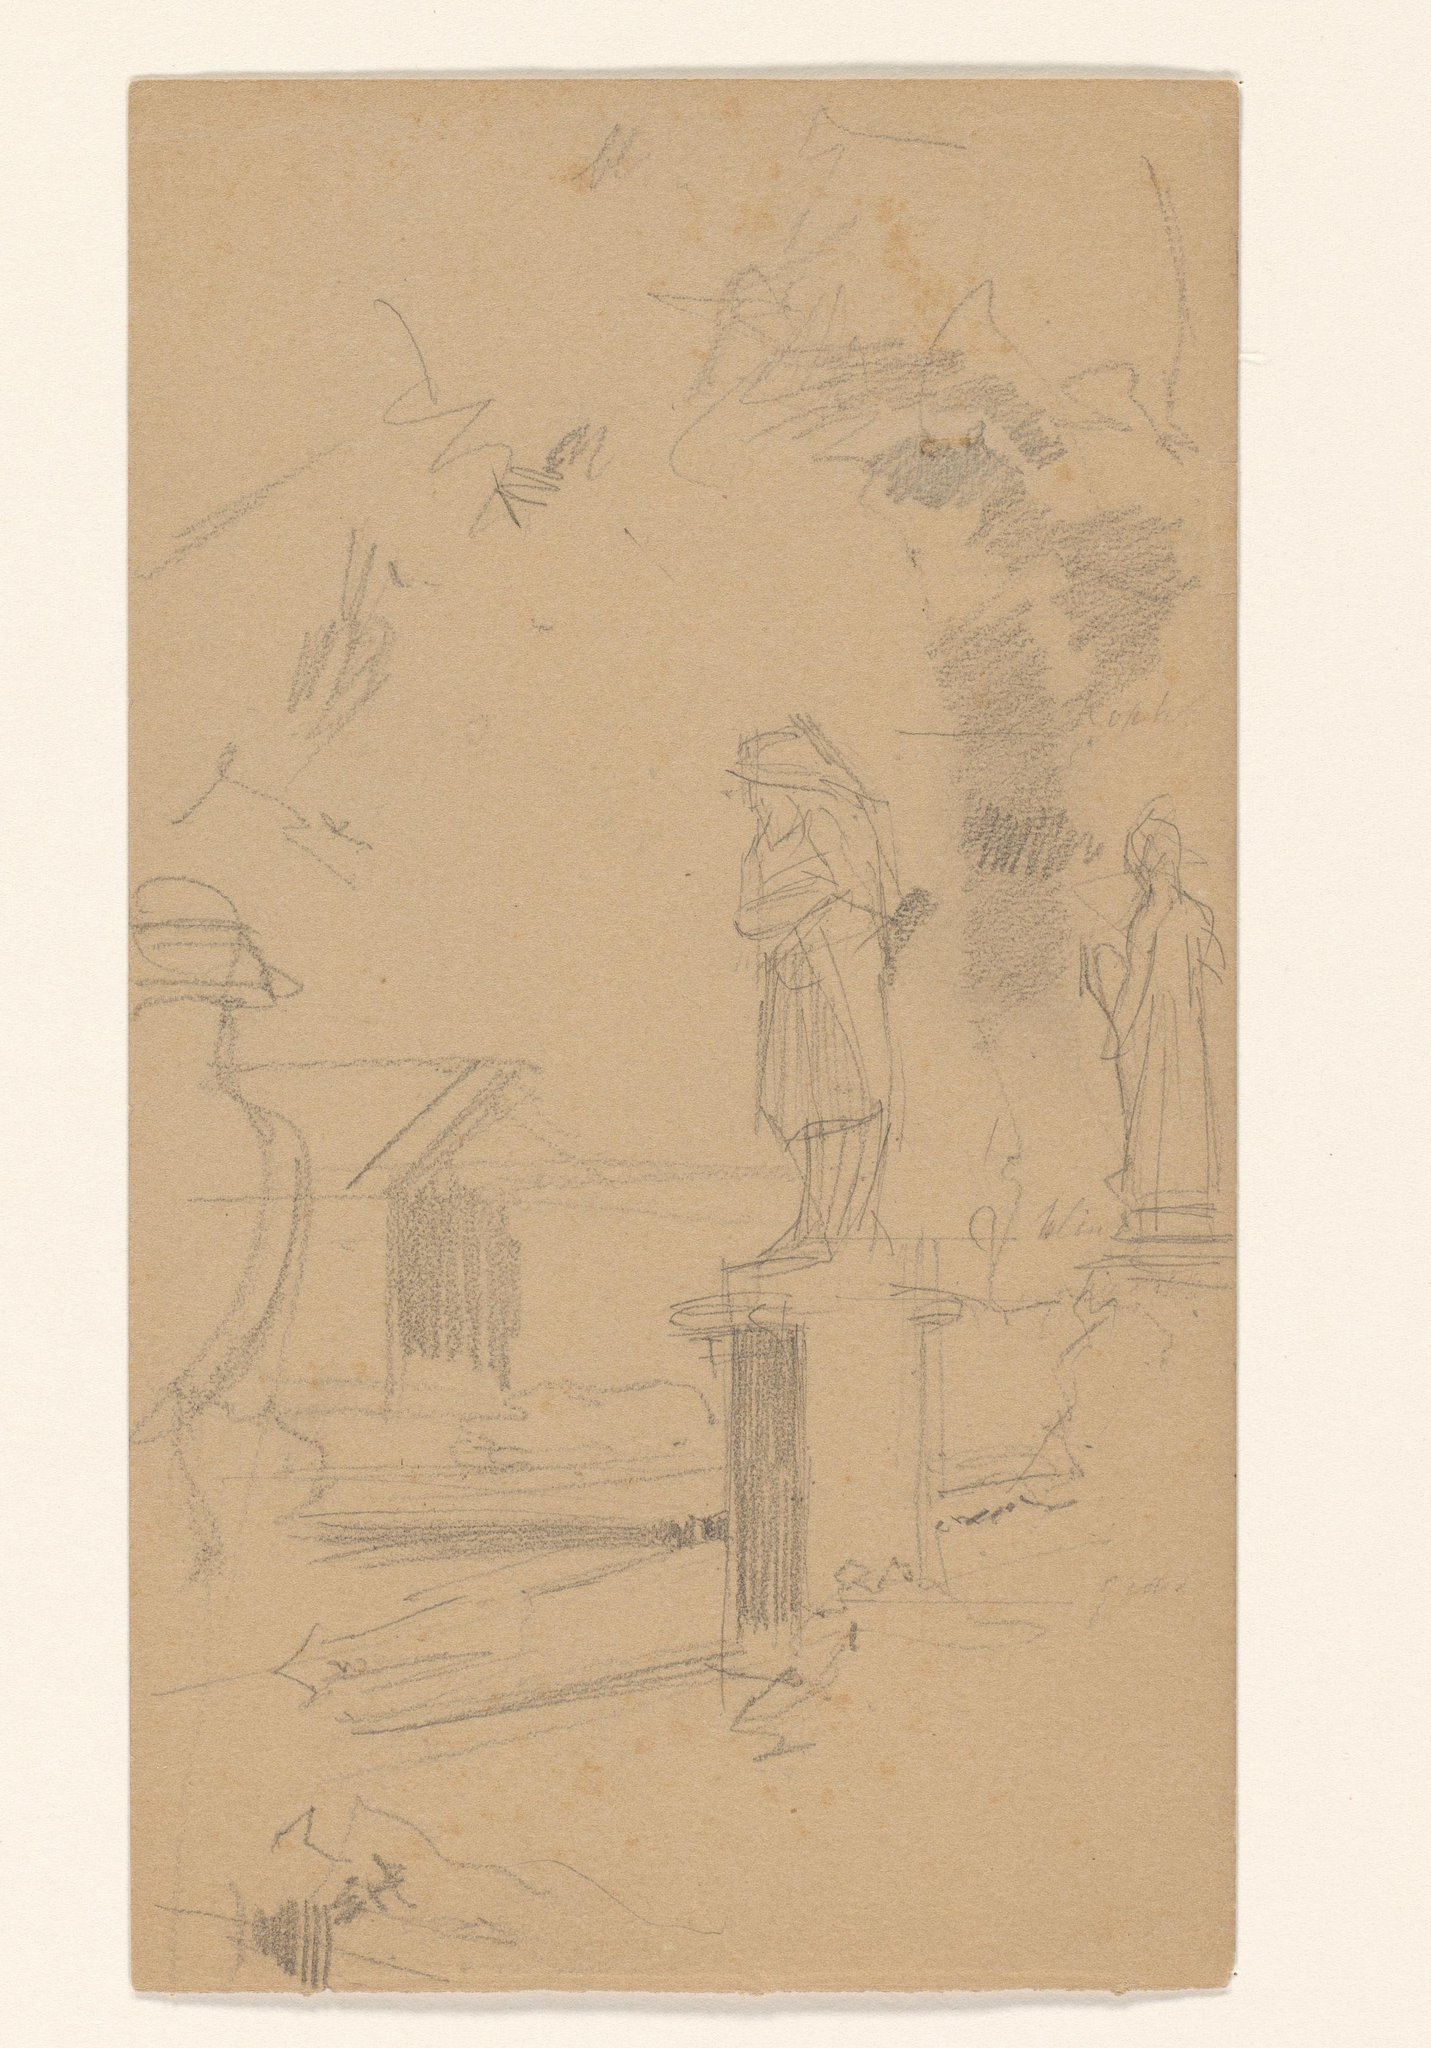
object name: drawing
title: Tuin met beelden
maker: august allebé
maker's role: draughtsman, print maker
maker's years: 1838-1927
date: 1848-1927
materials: paper, pencil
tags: garden, statues, sculptures in garden